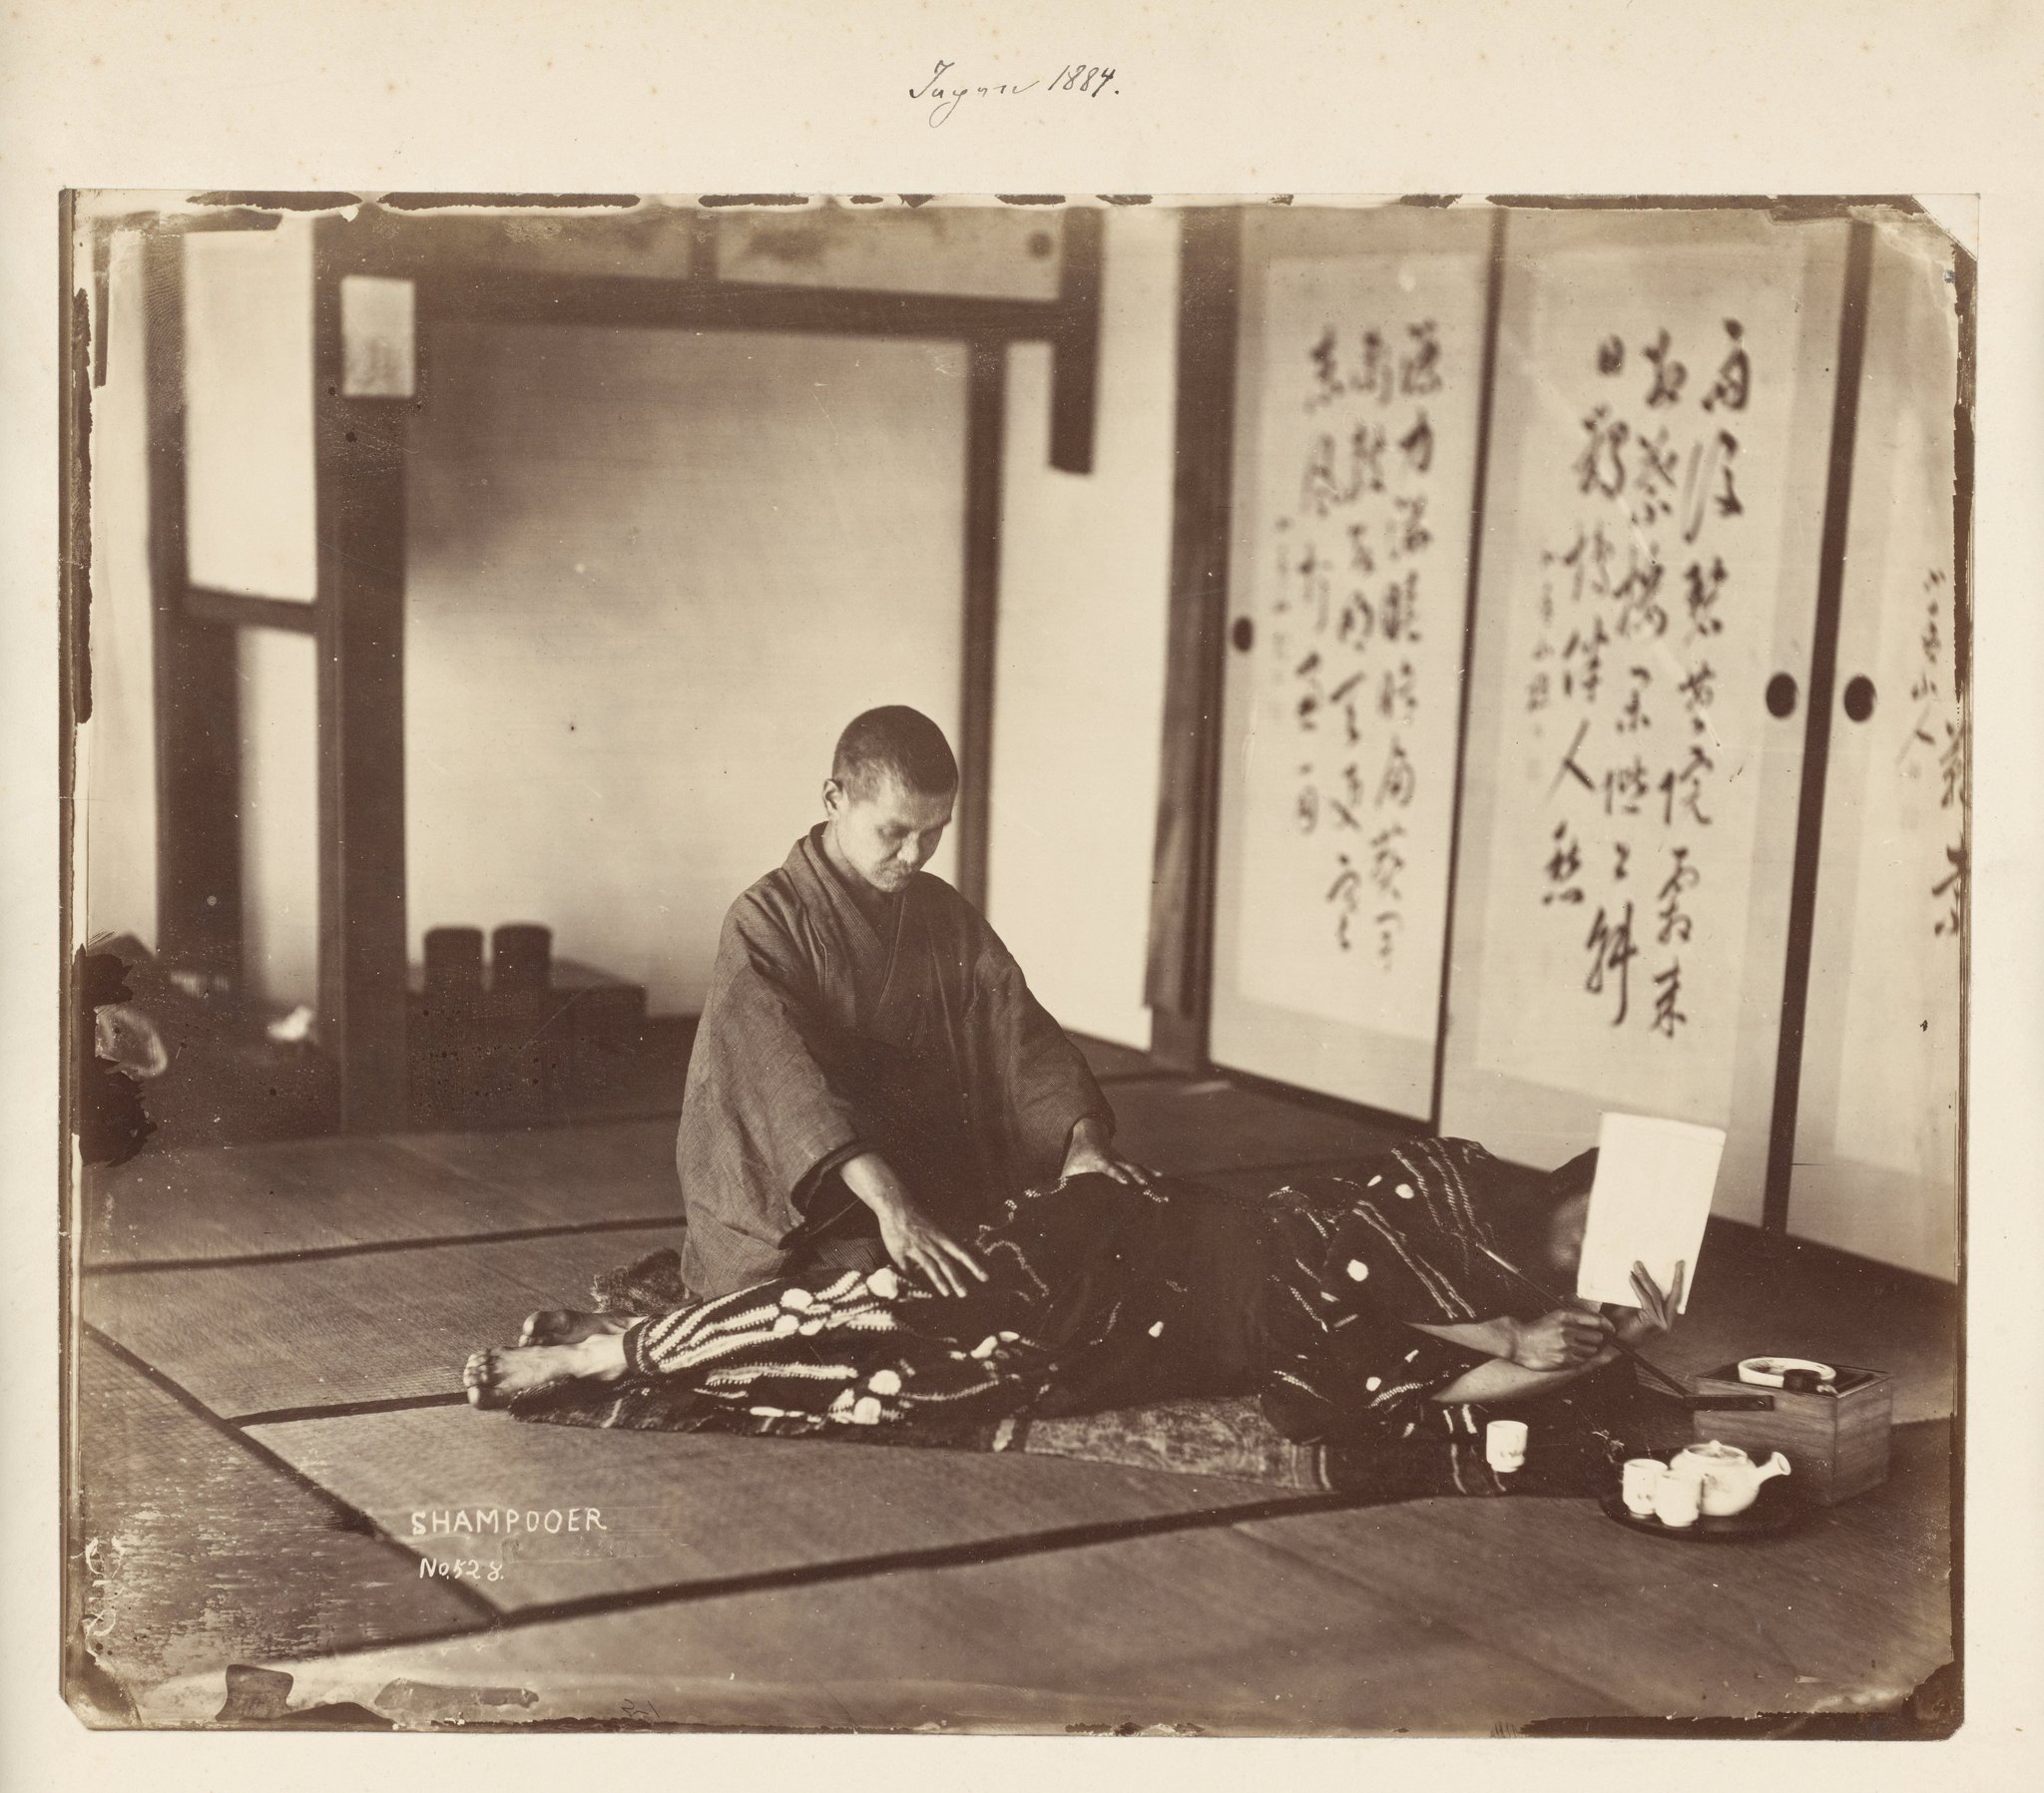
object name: photograph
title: Shampooer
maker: Anonymous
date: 1884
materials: cardboard, paper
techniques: albumen print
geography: japan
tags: massage ~ medical treatment, japan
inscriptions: number: ‘No.528’